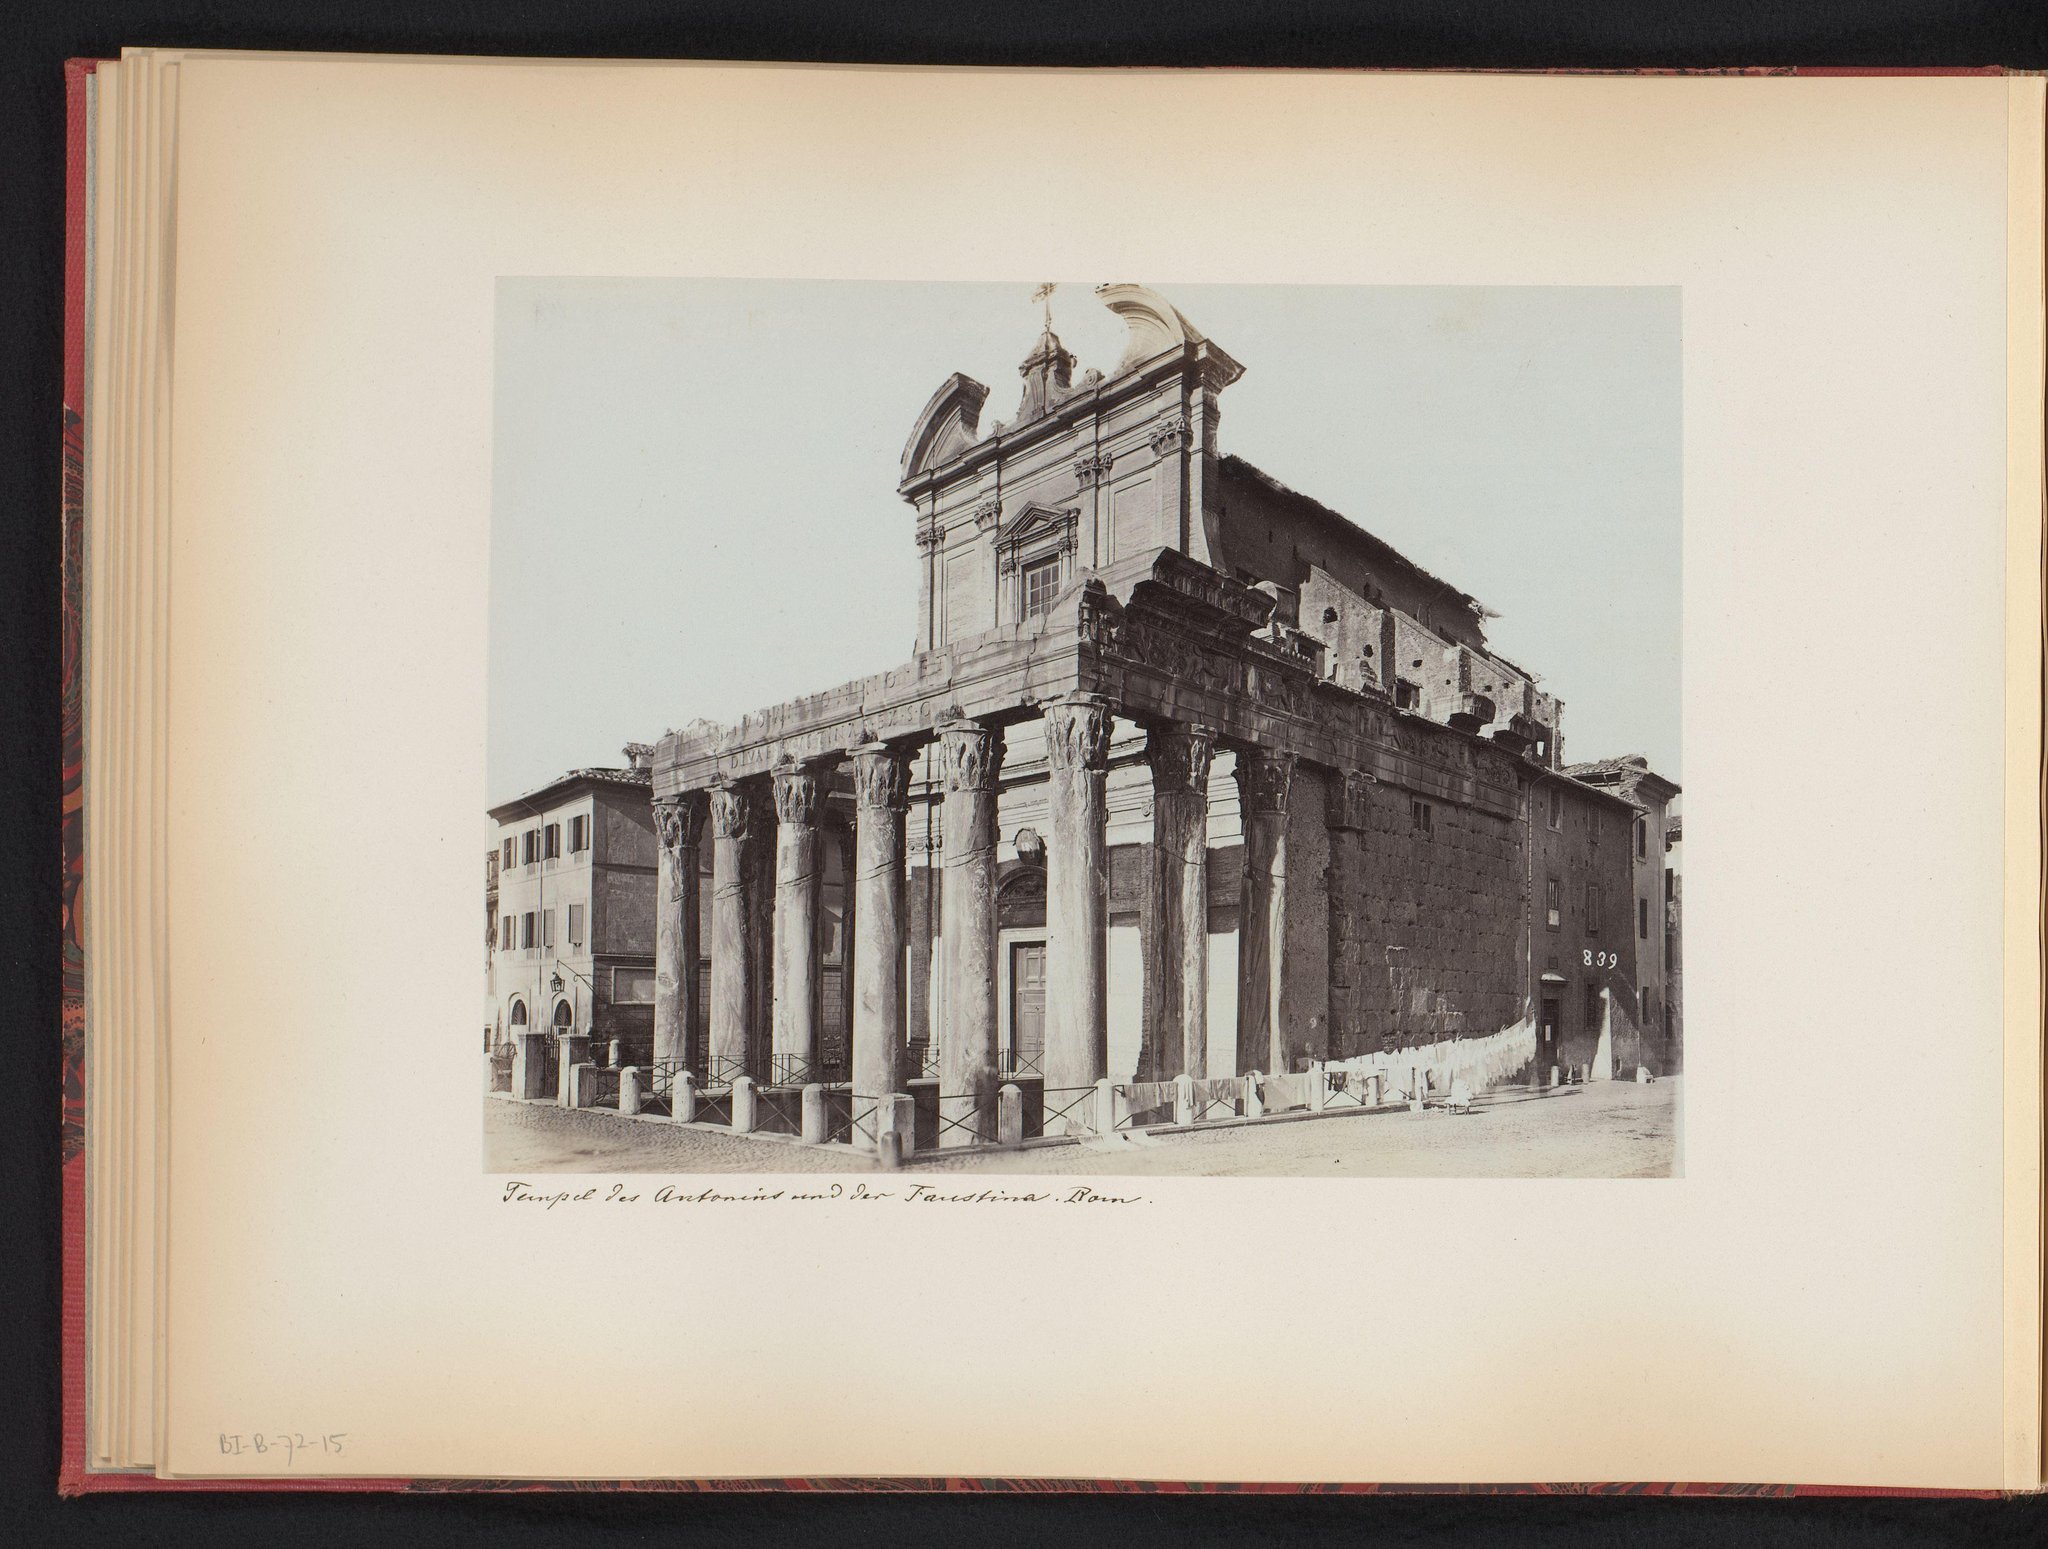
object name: album leaf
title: Tempel des Antonius und der Faustina. Rom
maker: Anonymous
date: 1870-1890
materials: paper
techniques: albumen print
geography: rome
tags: ruin of a building ~ architecture, temple, shrine ~ non-christian religions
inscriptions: inscription: ‘839’